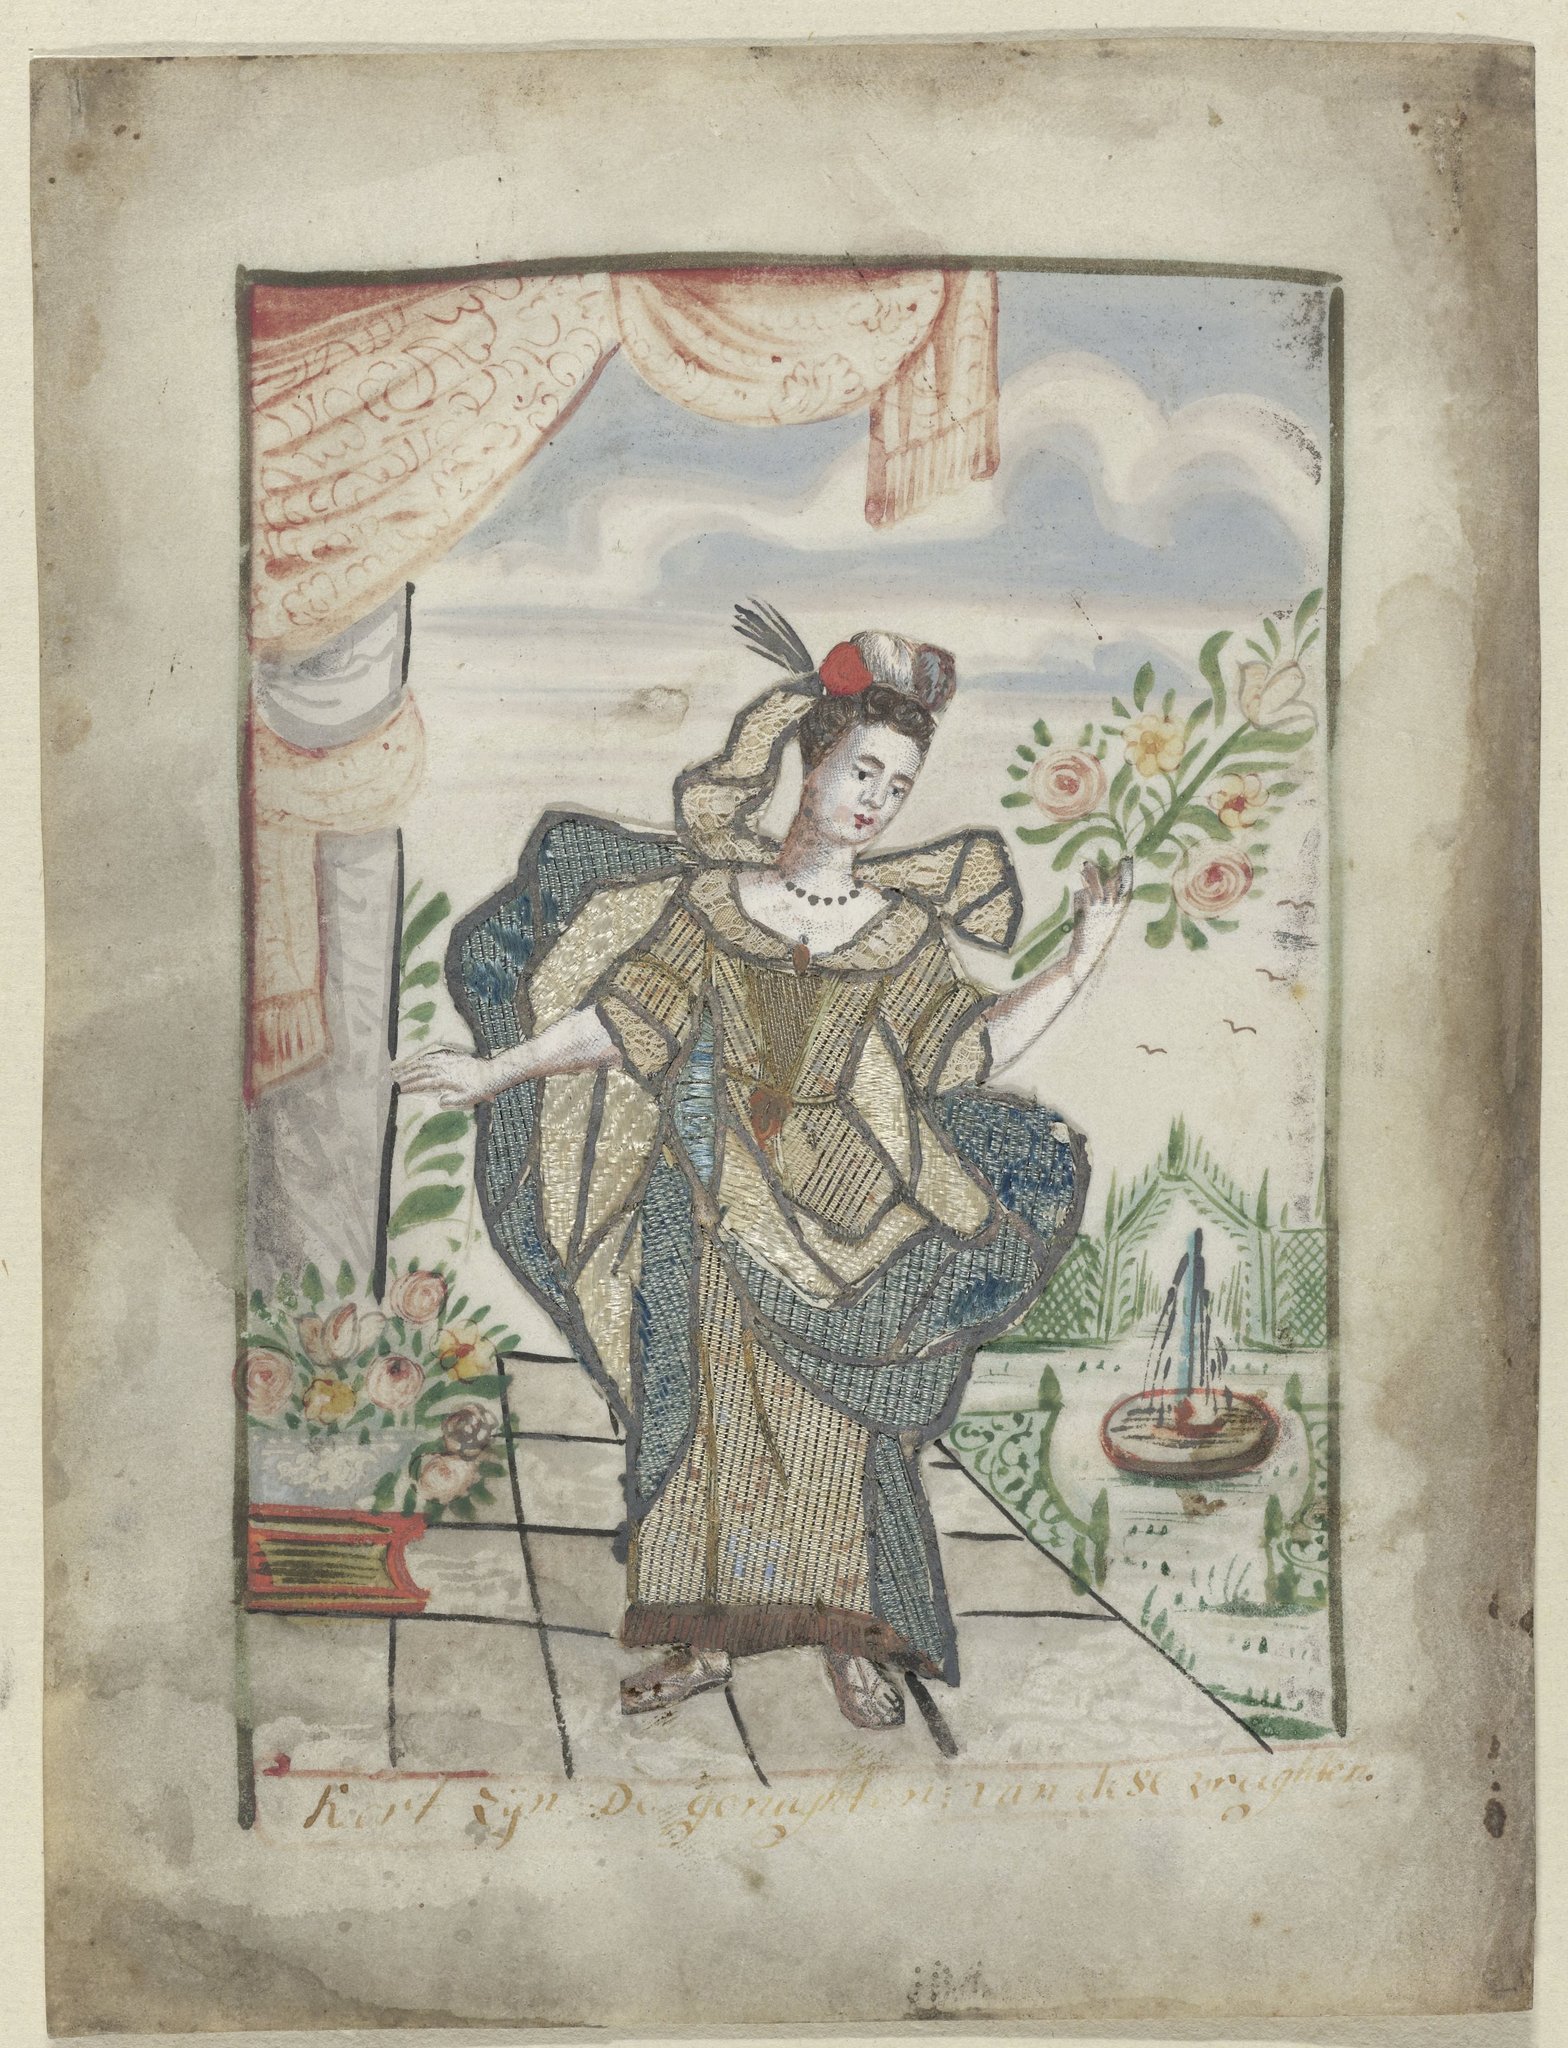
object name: drawing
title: Staande vrouw op een terras, een bloemtak in haar hand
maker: Anonymous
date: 1700-1799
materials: parchment, textile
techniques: brush, collage, printing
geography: netherlands